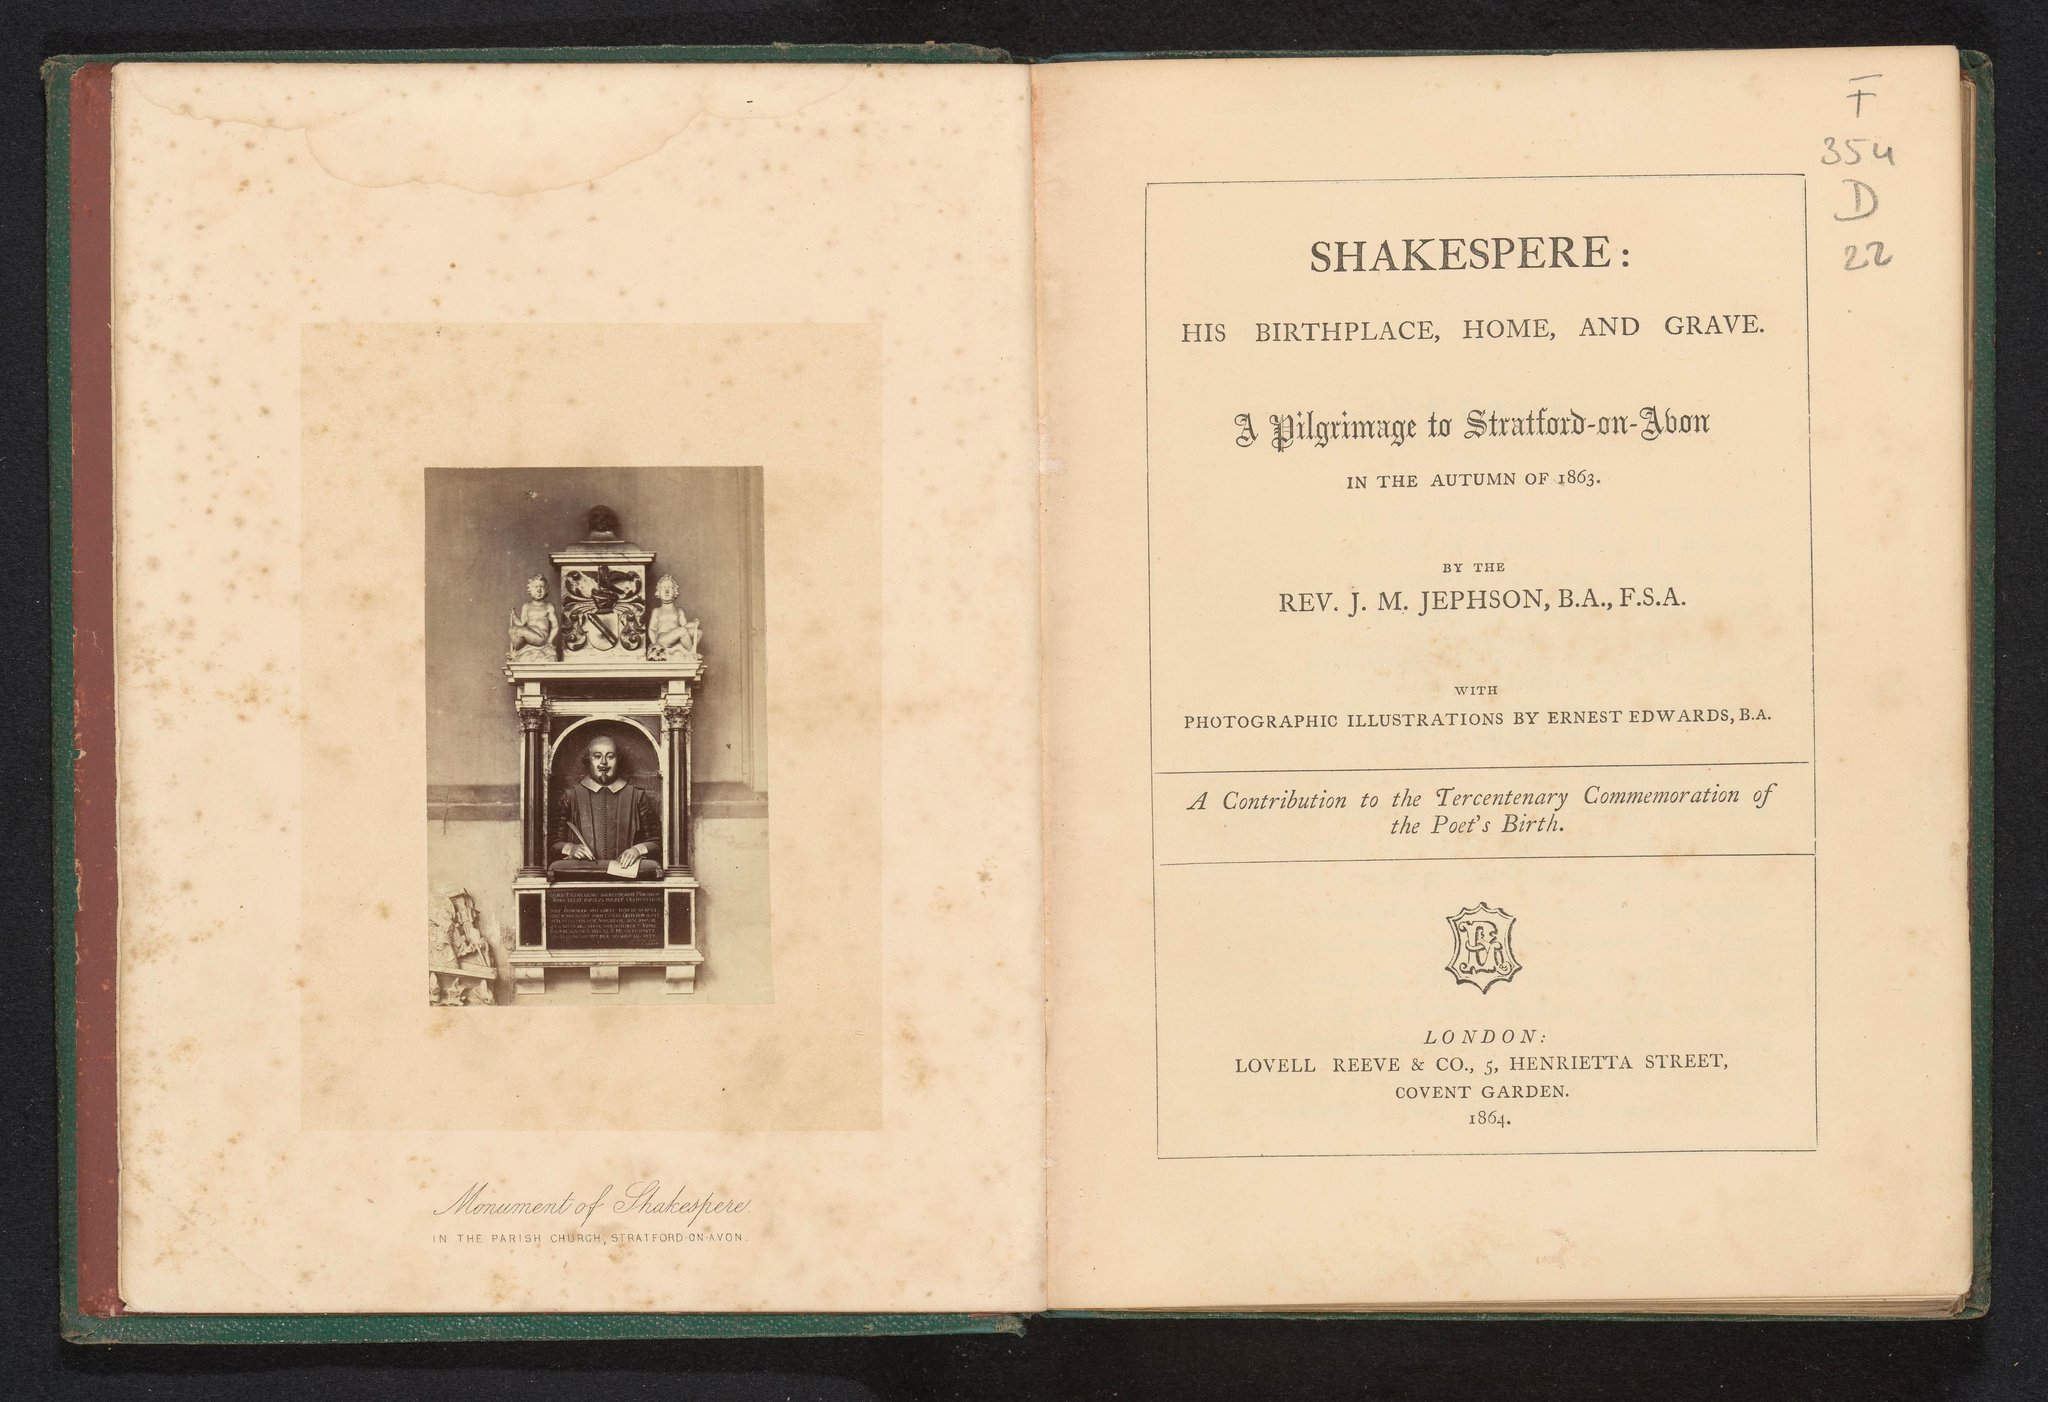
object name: page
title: Monument of Shakespere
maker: ernest edwards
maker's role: fotograaf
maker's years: 1837-1903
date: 1863-1864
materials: photographic support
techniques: albumen print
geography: holy trinity church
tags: sculpture, grave, tomb and other grave-forms and grave-markers